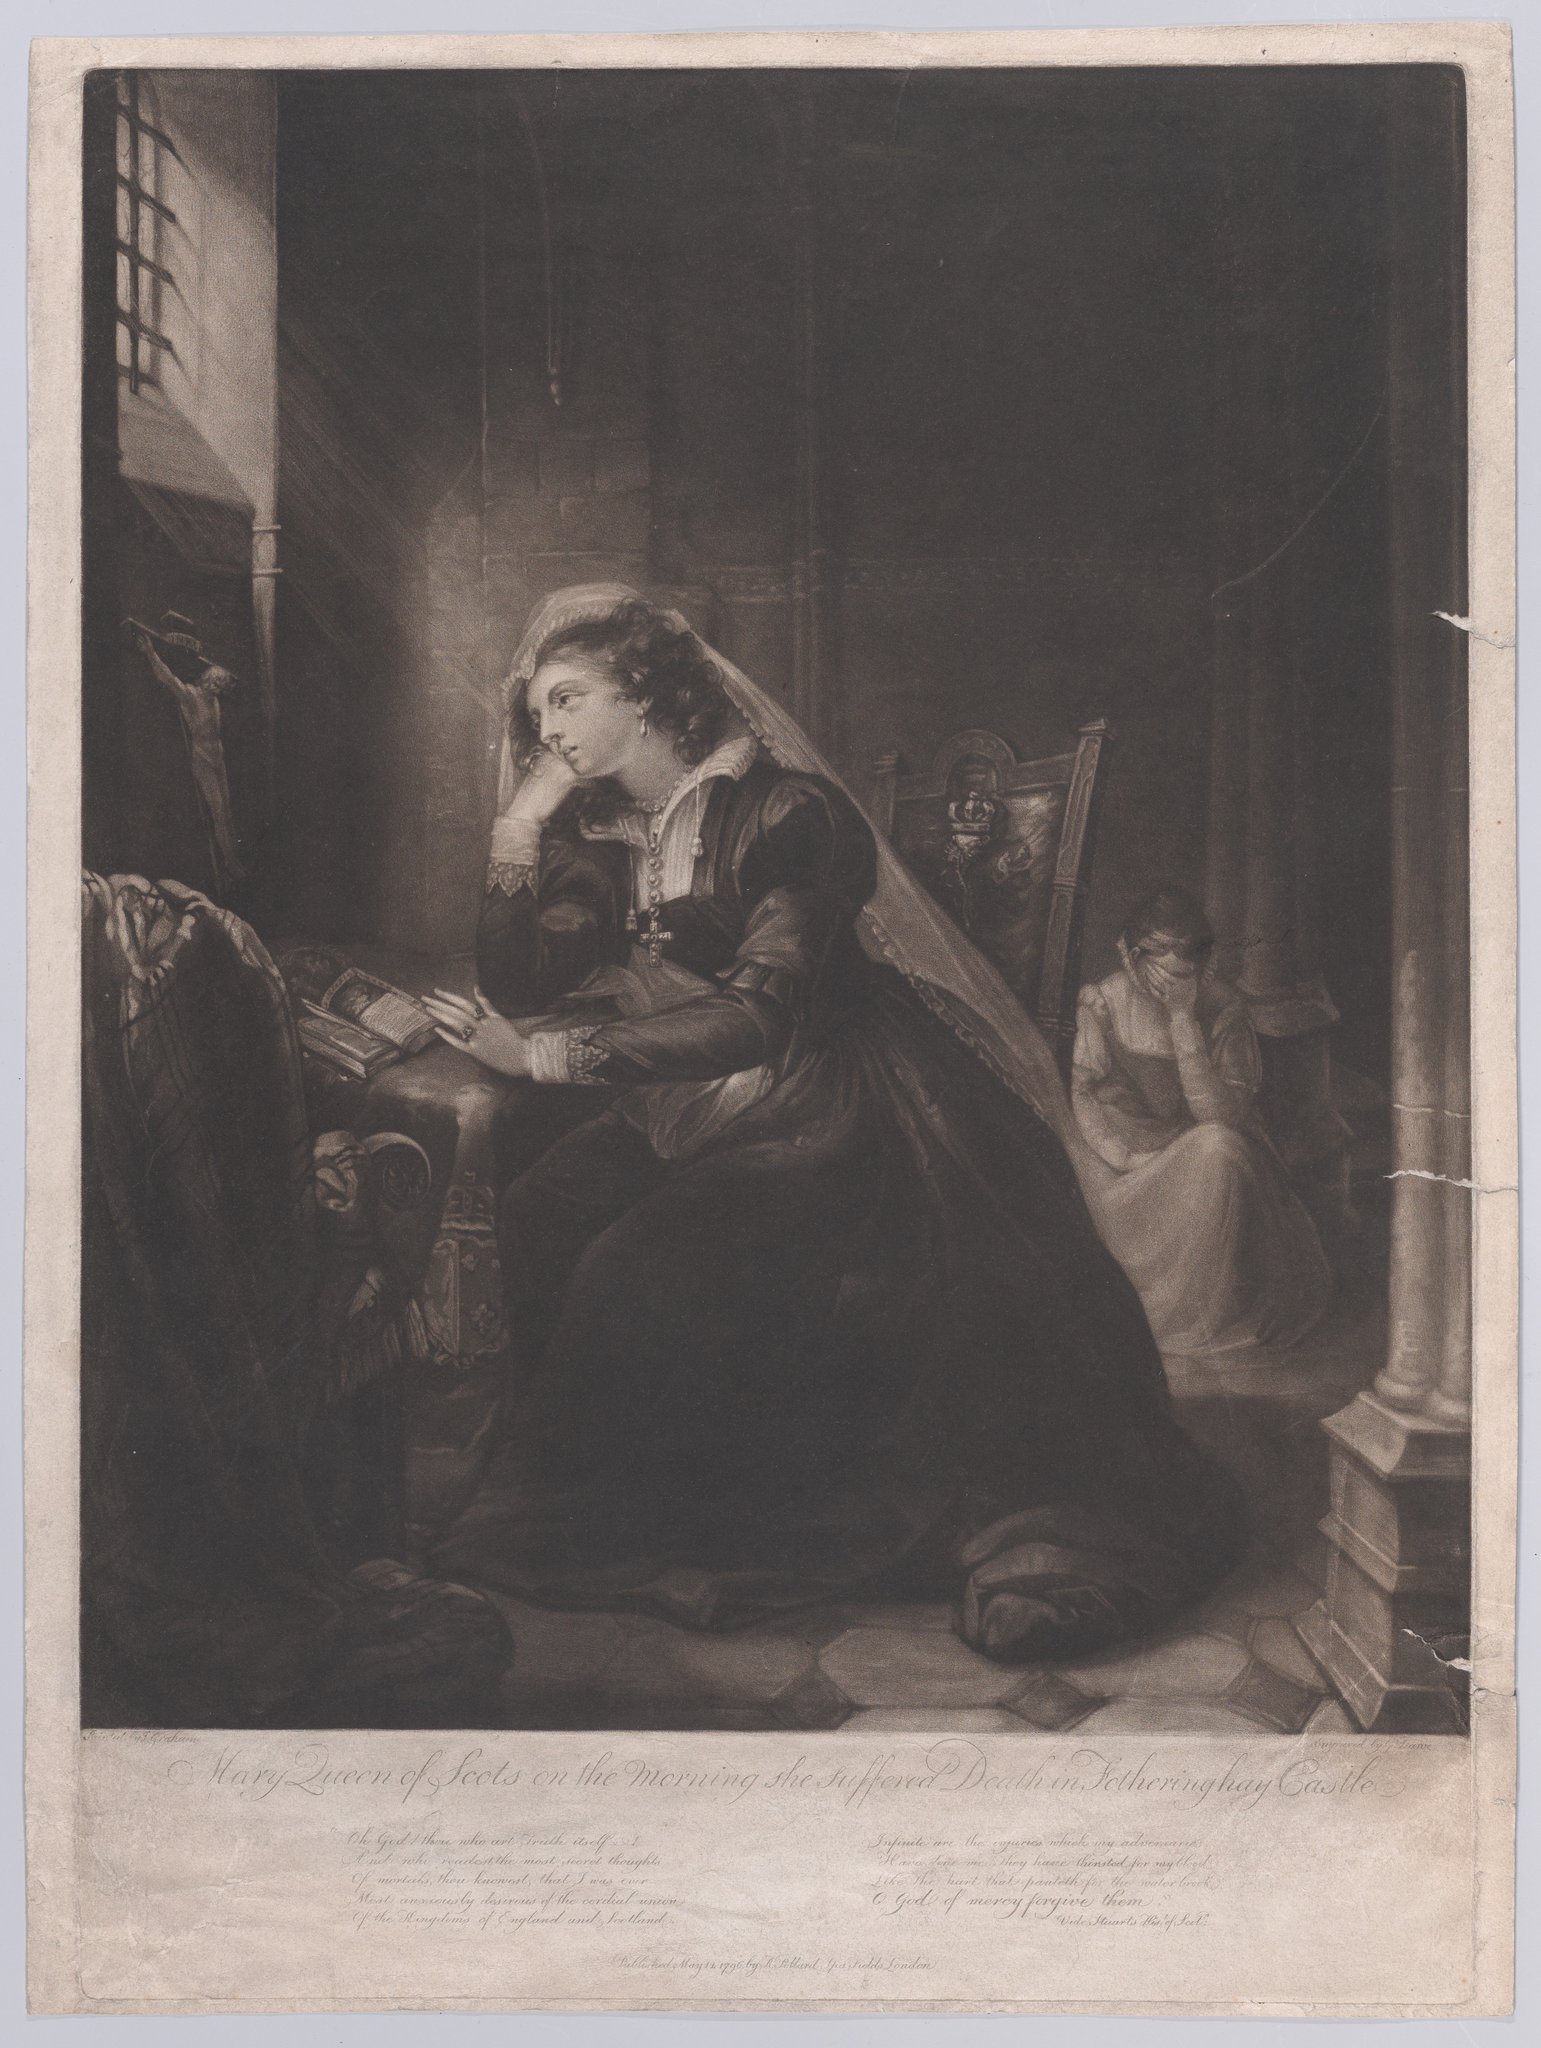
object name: print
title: Mary, Queen of Scots, on the morning she suffered Death in Fotheringhay Castle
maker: george dawe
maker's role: artist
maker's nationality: british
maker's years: 1781-1829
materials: steel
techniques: etching, mezzotint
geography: england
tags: queens,women,mary queen of scots